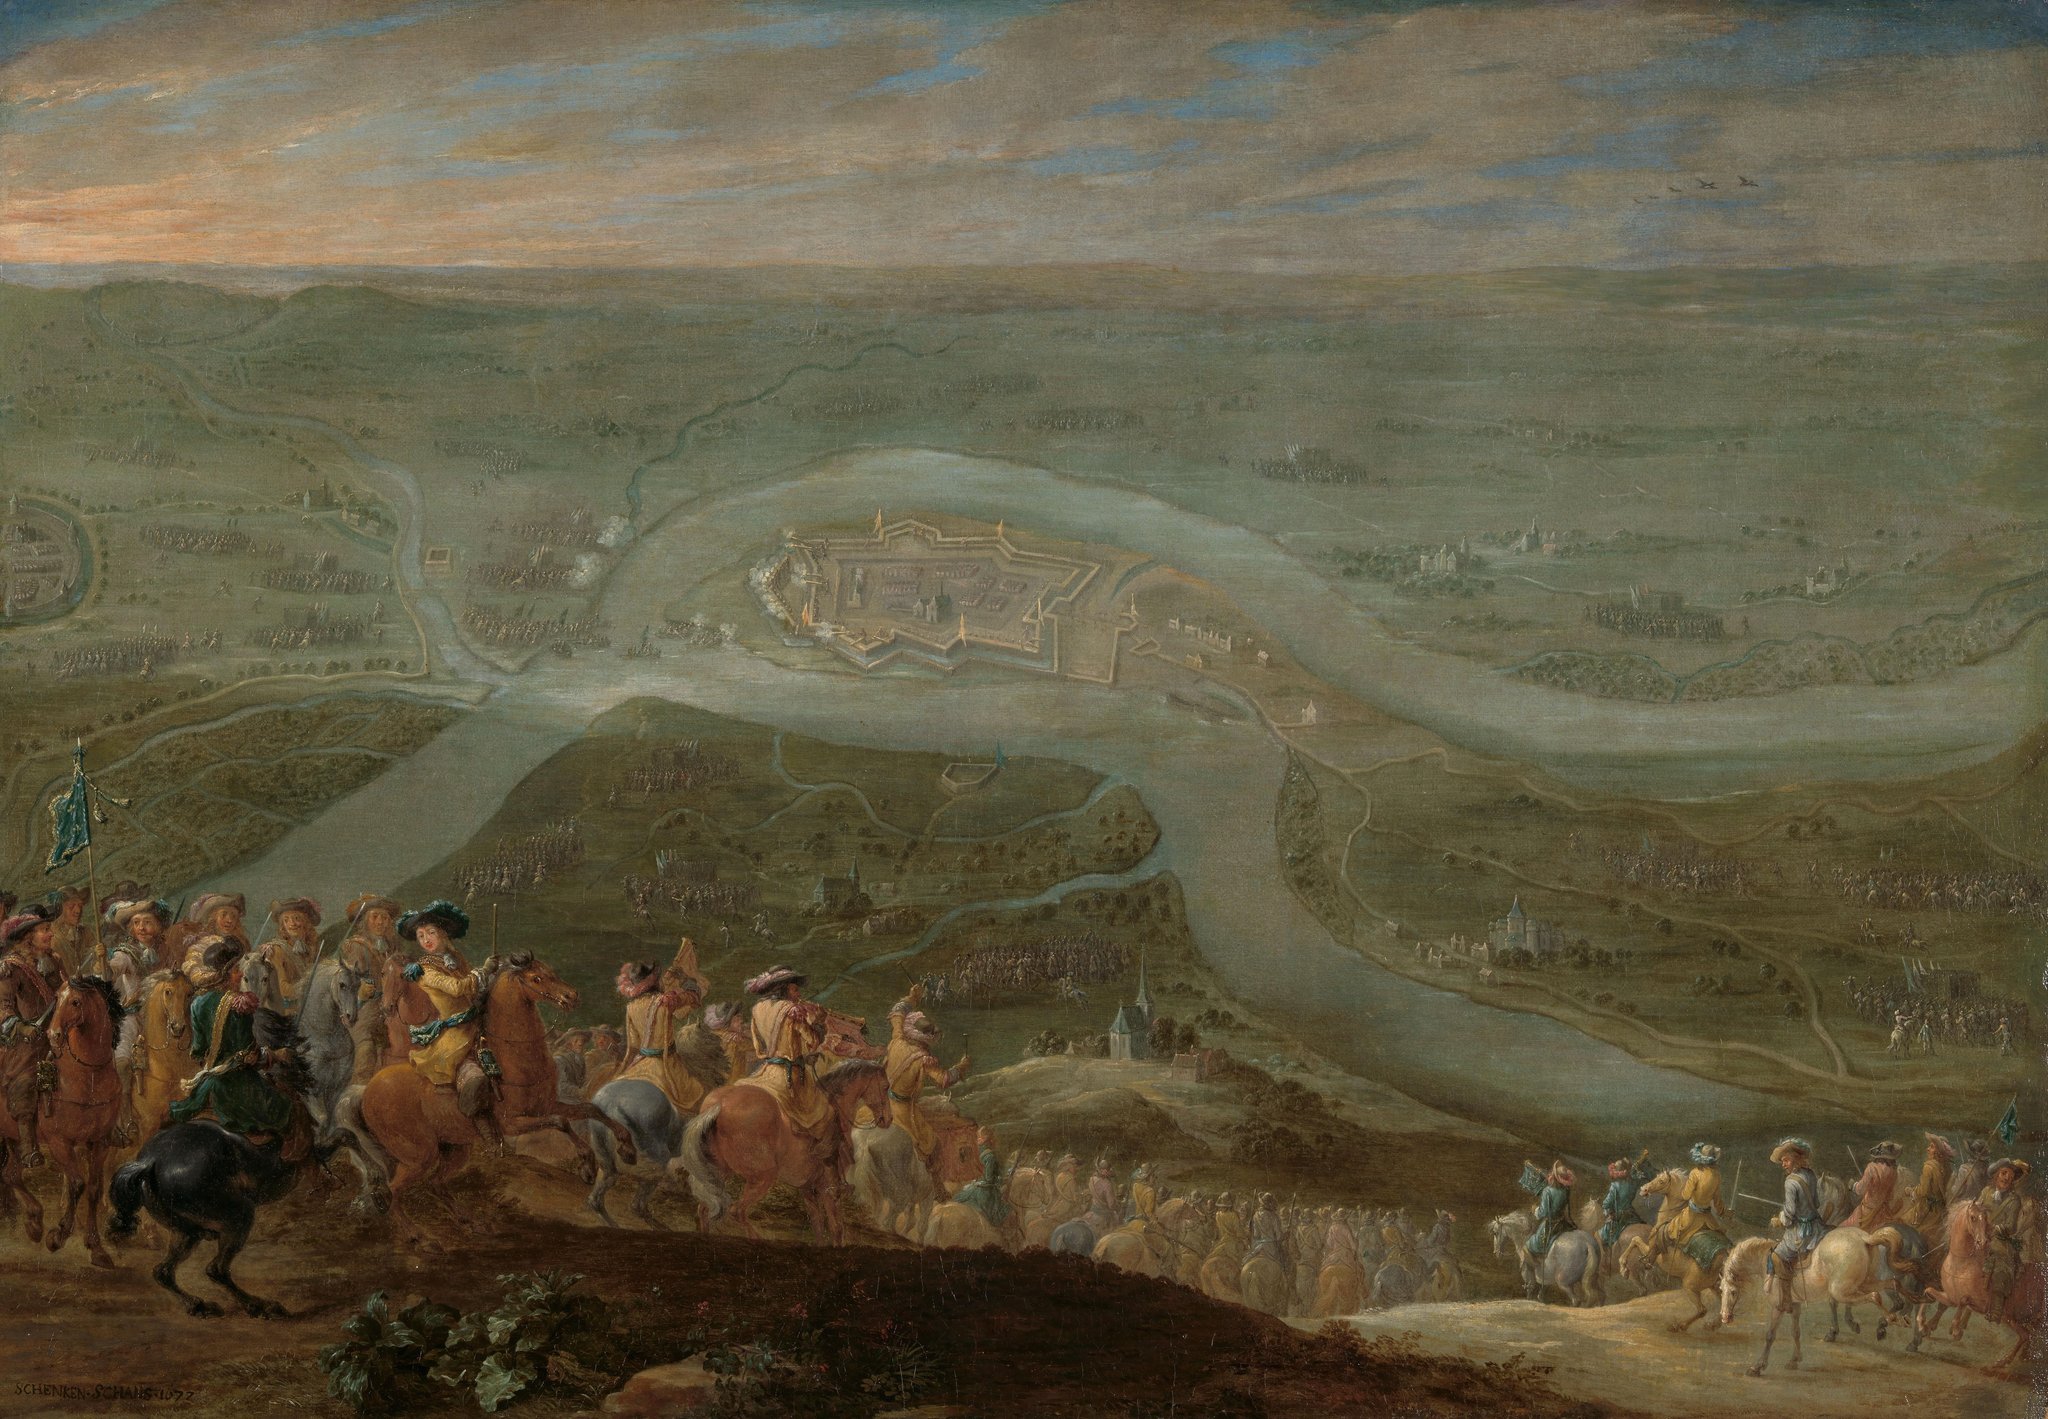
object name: painting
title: King Louis XIV and his Entourage at the Siege of Schenkenschans, 1672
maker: lambert de hondt (ii)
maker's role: painter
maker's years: 1642-1709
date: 1675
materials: canvas, oil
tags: lodewijk xiv (koning van frankrijk), fortress, attack ~ siege, rampjaar (disaster year)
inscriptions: inscription, bottom left: ‘SCHENKEN·SCHANS·167[2]’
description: The French army at Schenkenschans, 18-19 June 1672. Attributed to Lambert de Hondt II, 1672. Schenkenschans was a fortress on a strategic promontory in the Rhine at Lobith. After the French army had crossed the Rhine, Schenkenschans was attacked and captured from Arnhem. The French troops were commanded by the 61-year-old Marshal Turenne, who had served in the Republic's army as a young man. Turenne is shown in the foreground, directing his troops down the hill with his staff. Schenkenschans is depicted from the air. The French are approaching the fortress from all sides.